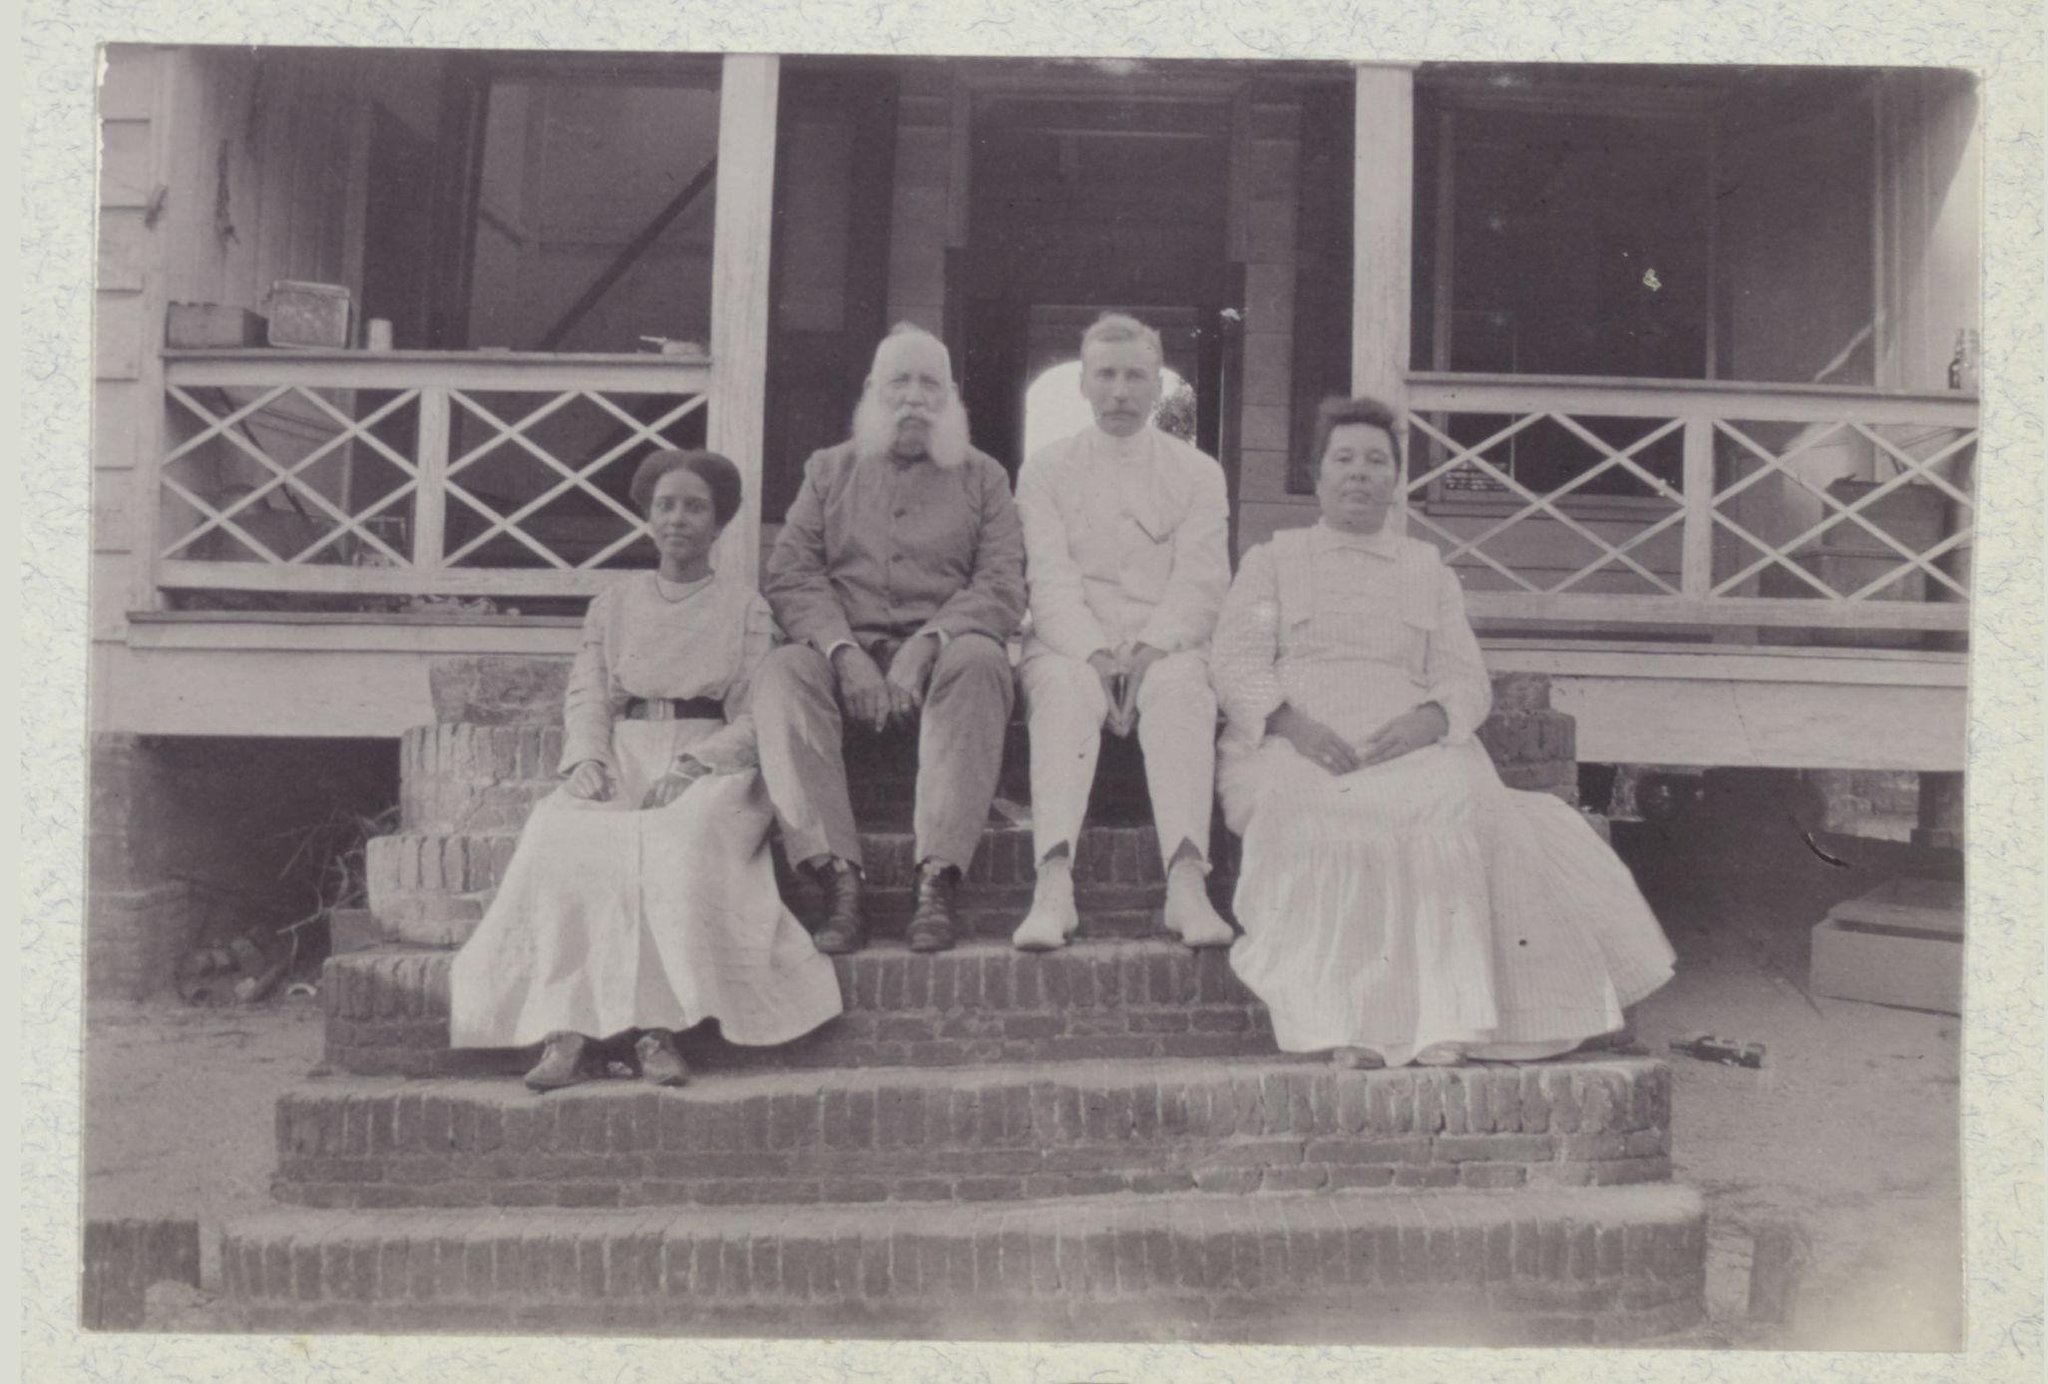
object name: photograph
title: Plantage Caledonia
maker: Anonymous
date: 1911-1912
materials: photographic support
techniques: photography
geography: suriname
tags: amsterdam, andries augustus boom, plantation, suriname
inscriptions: inscription: ‘Plantage Caledonie’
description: Andries Boom zittend met drie anderen op de trap van het huis op Plantage Caledonia, ca. 1911-1912. Onderdeel van het fotoalbum van de familie Boom-Gonggrijp in Suriname en Curaçao.